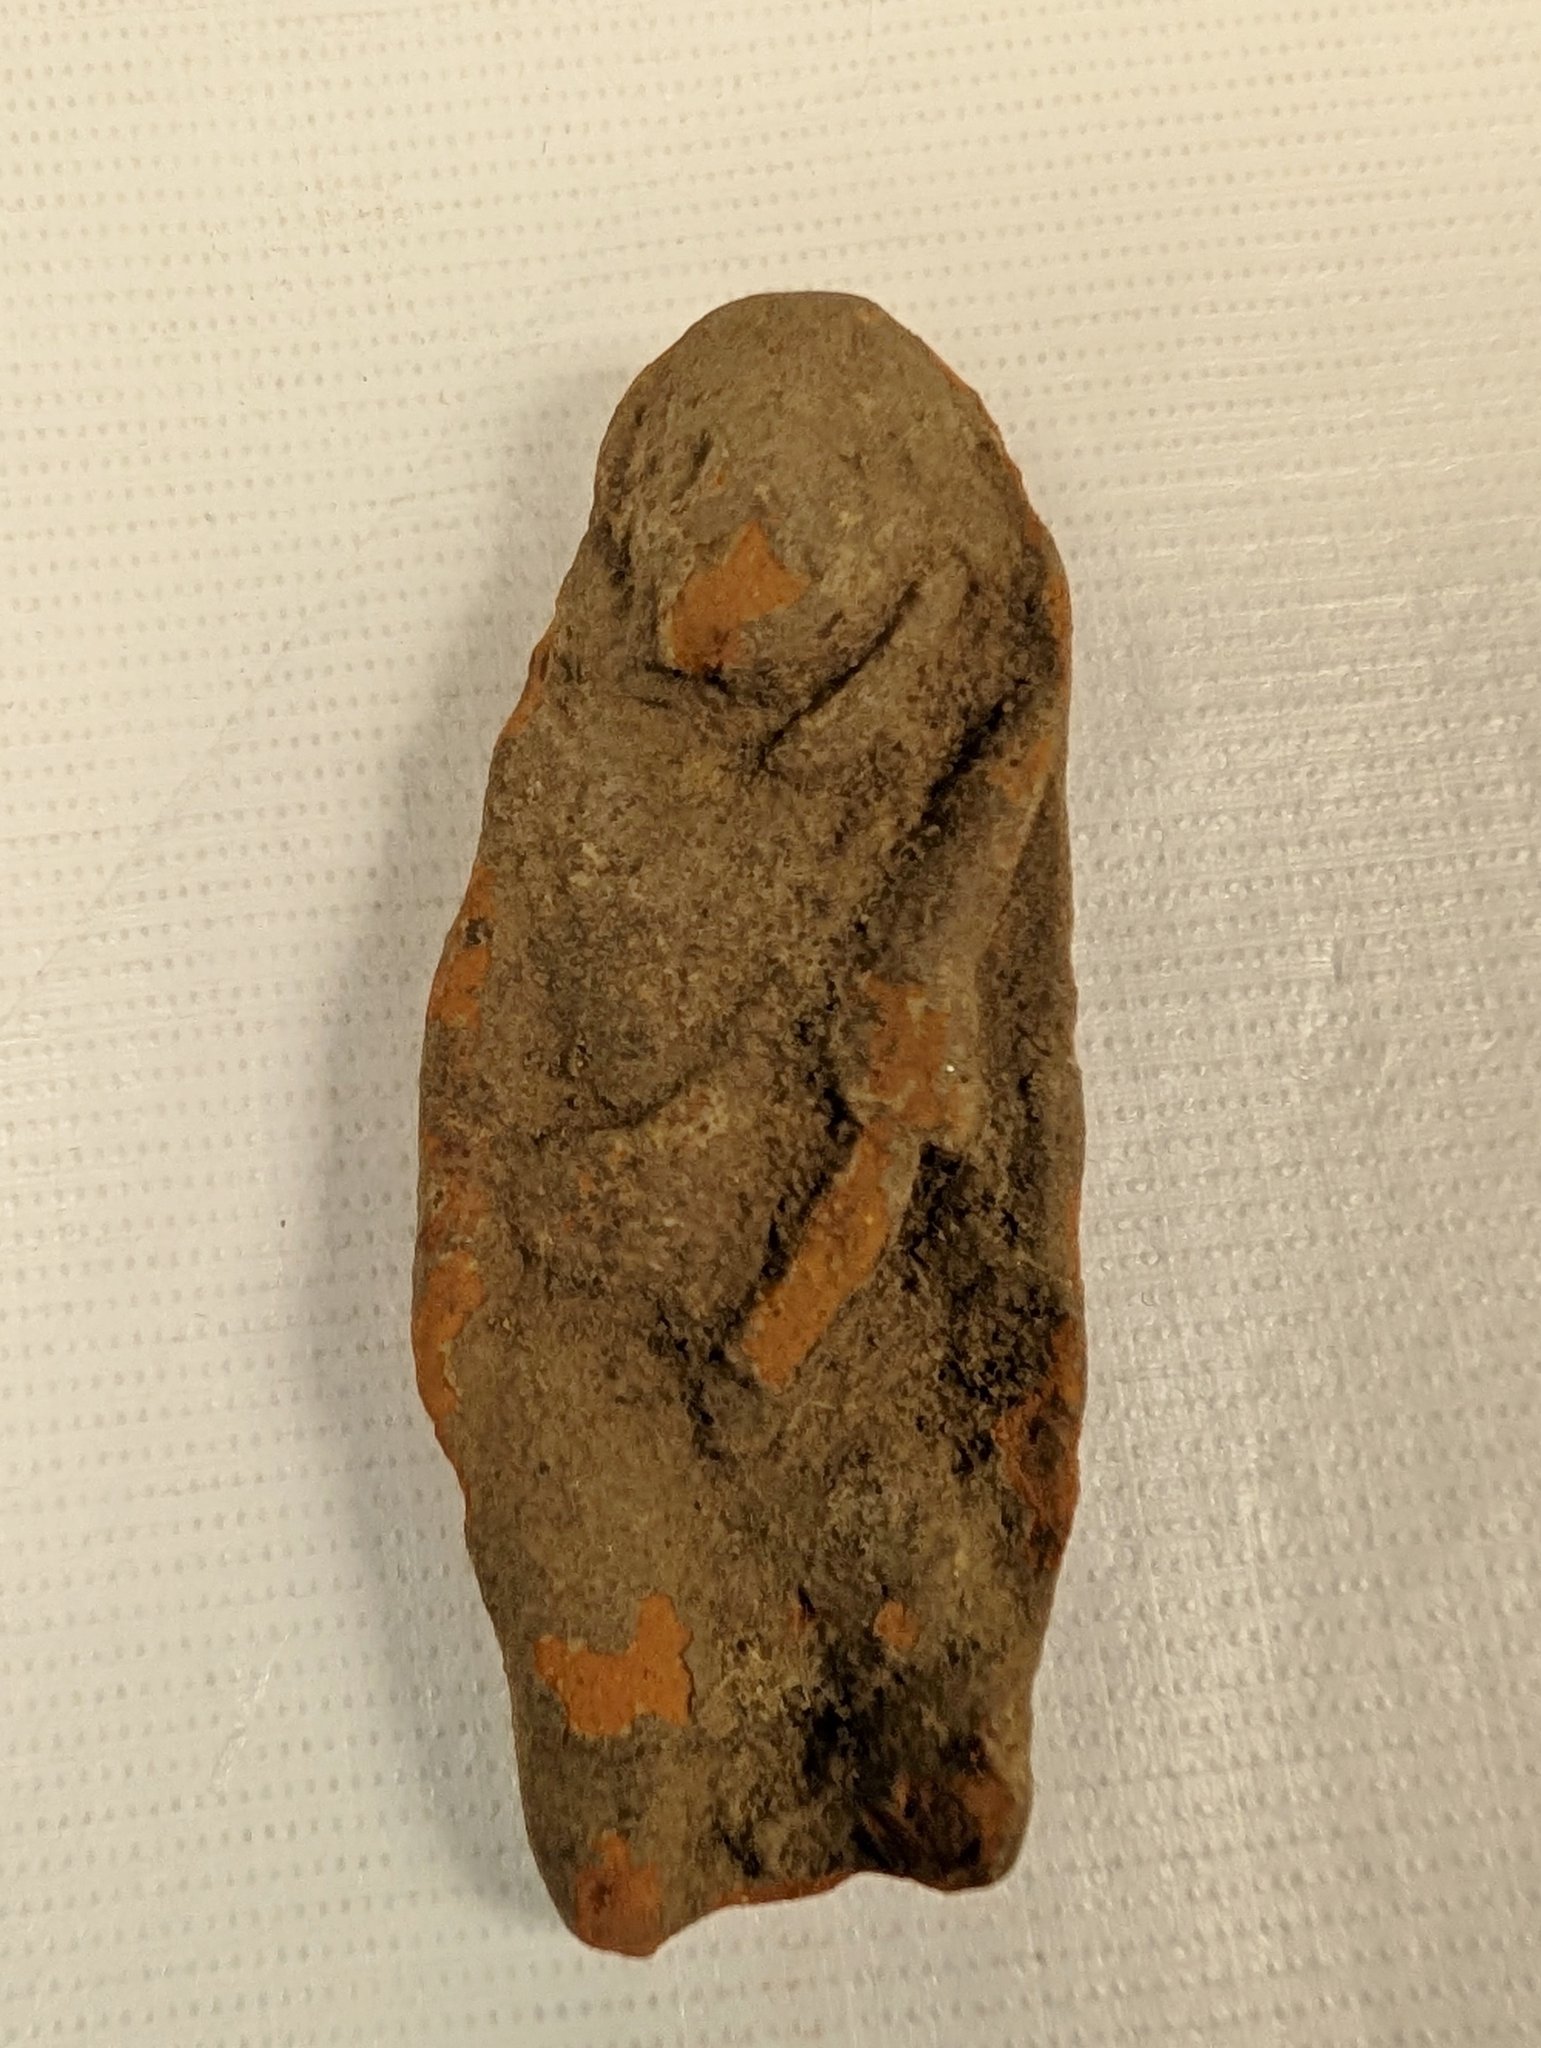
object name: plaque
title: Plaque in the Form of a Female Figure (Study Collection)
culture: pakistani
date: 101-300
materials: terracotta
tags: gandhara